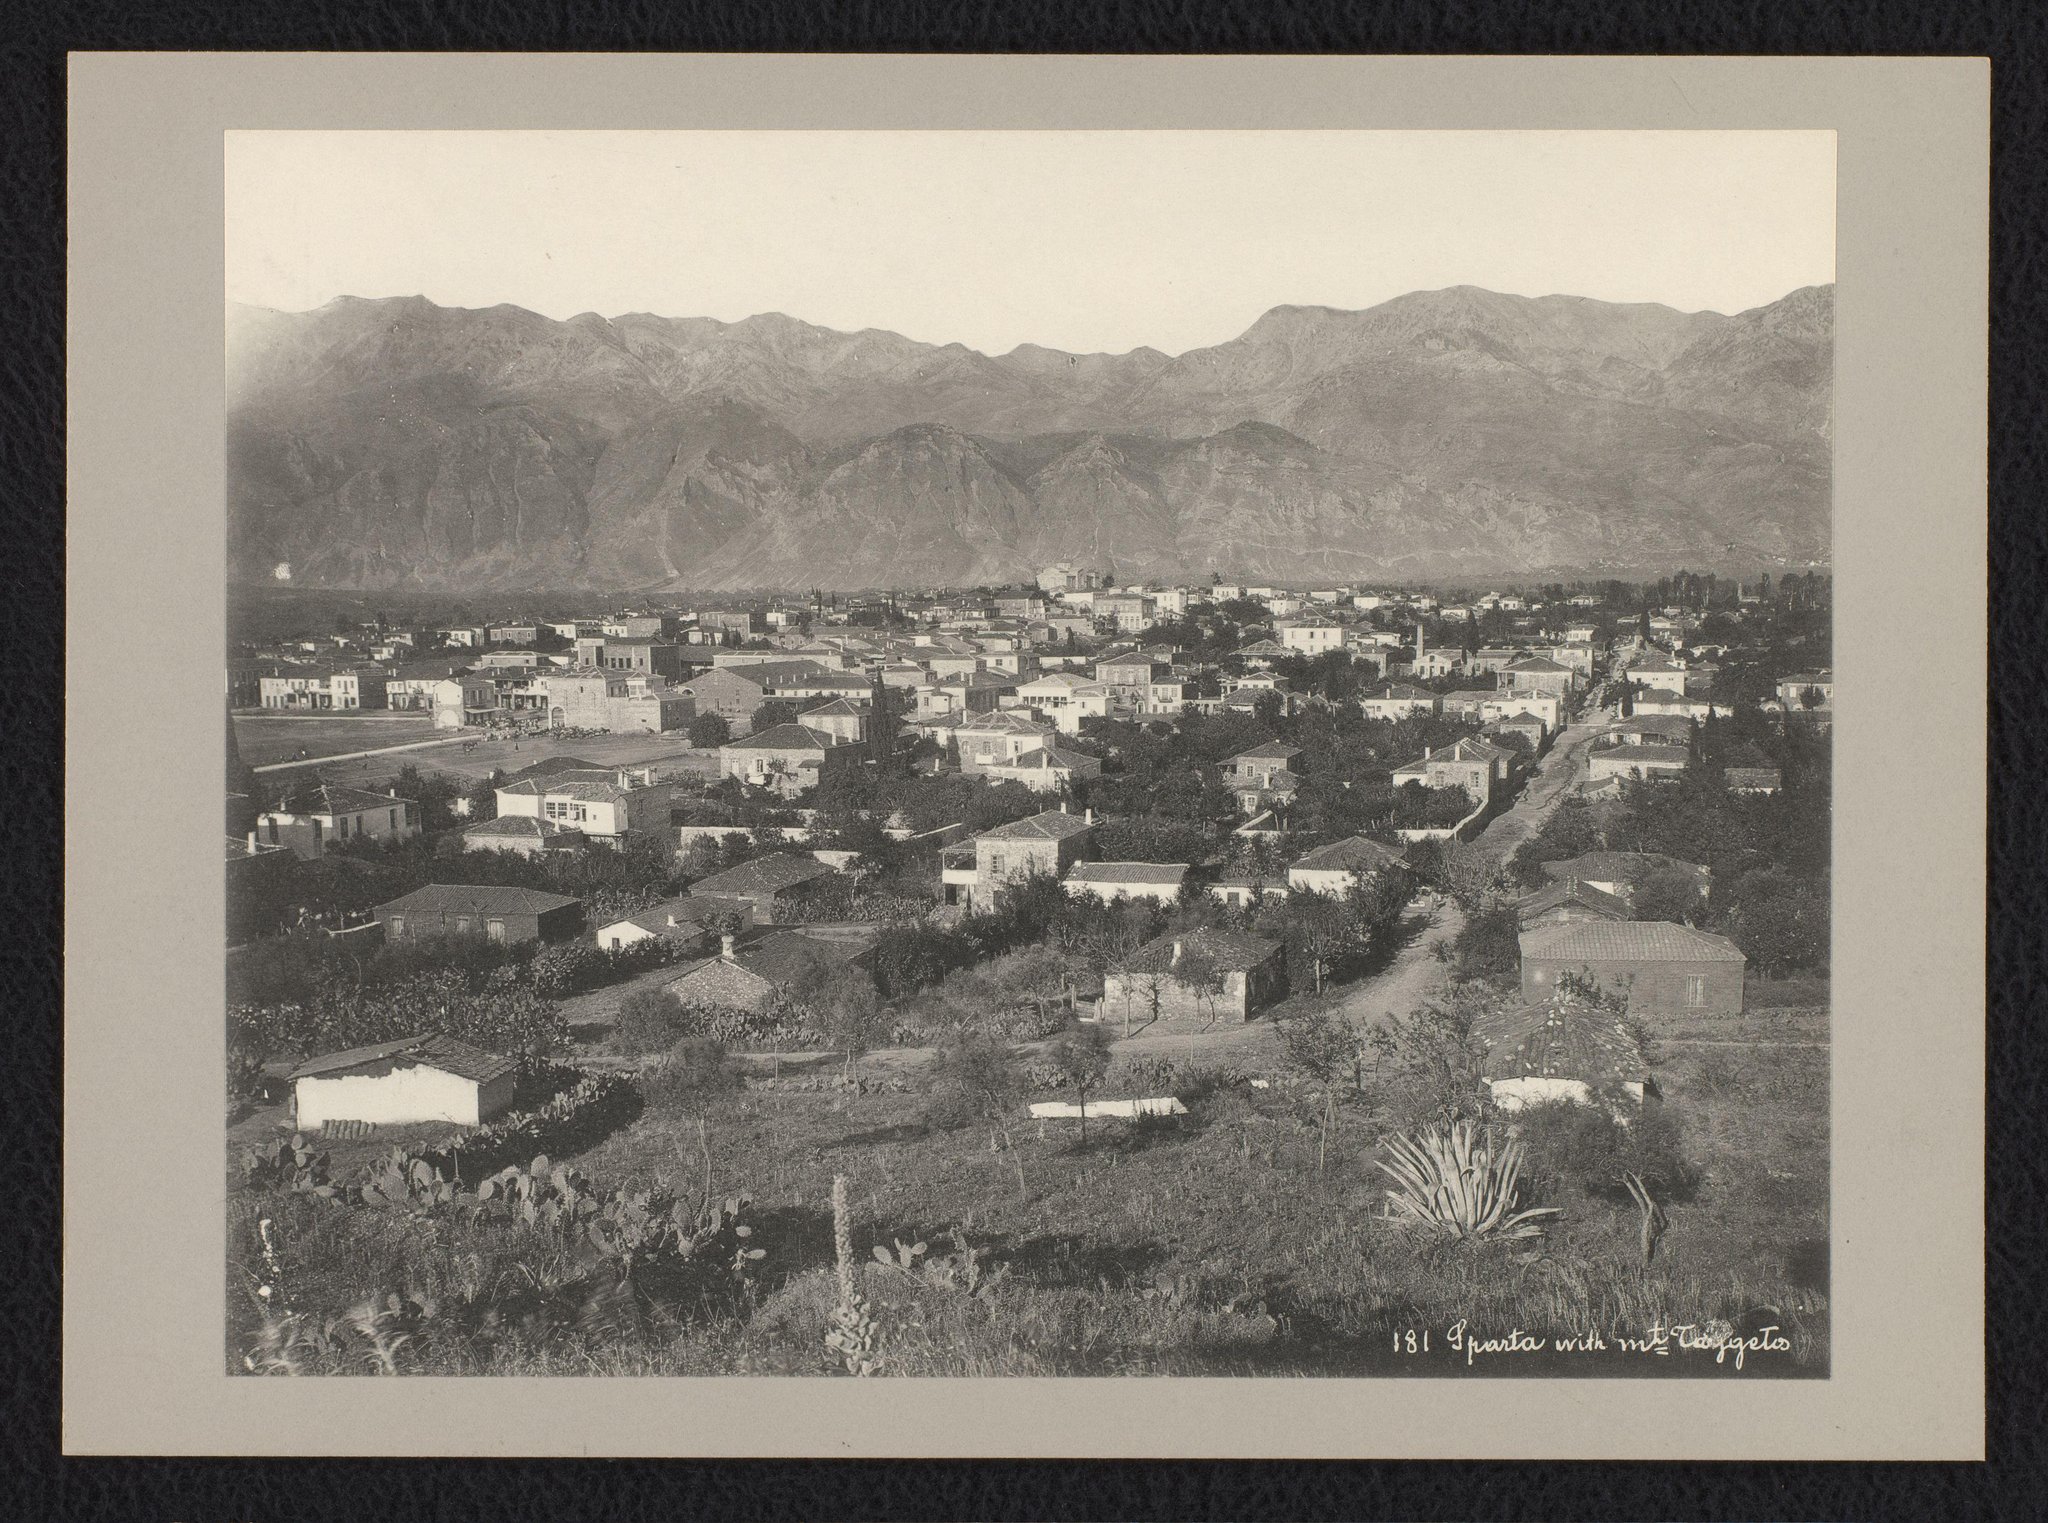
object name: photograph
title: Gezicht op Sparta met op de achtergrond de berg Taygeto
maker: Anonymous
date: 1895-1915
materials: cardboard, paper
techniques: photograph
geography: peloponnese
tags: pelopónnesos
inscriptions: number: ‘6.’